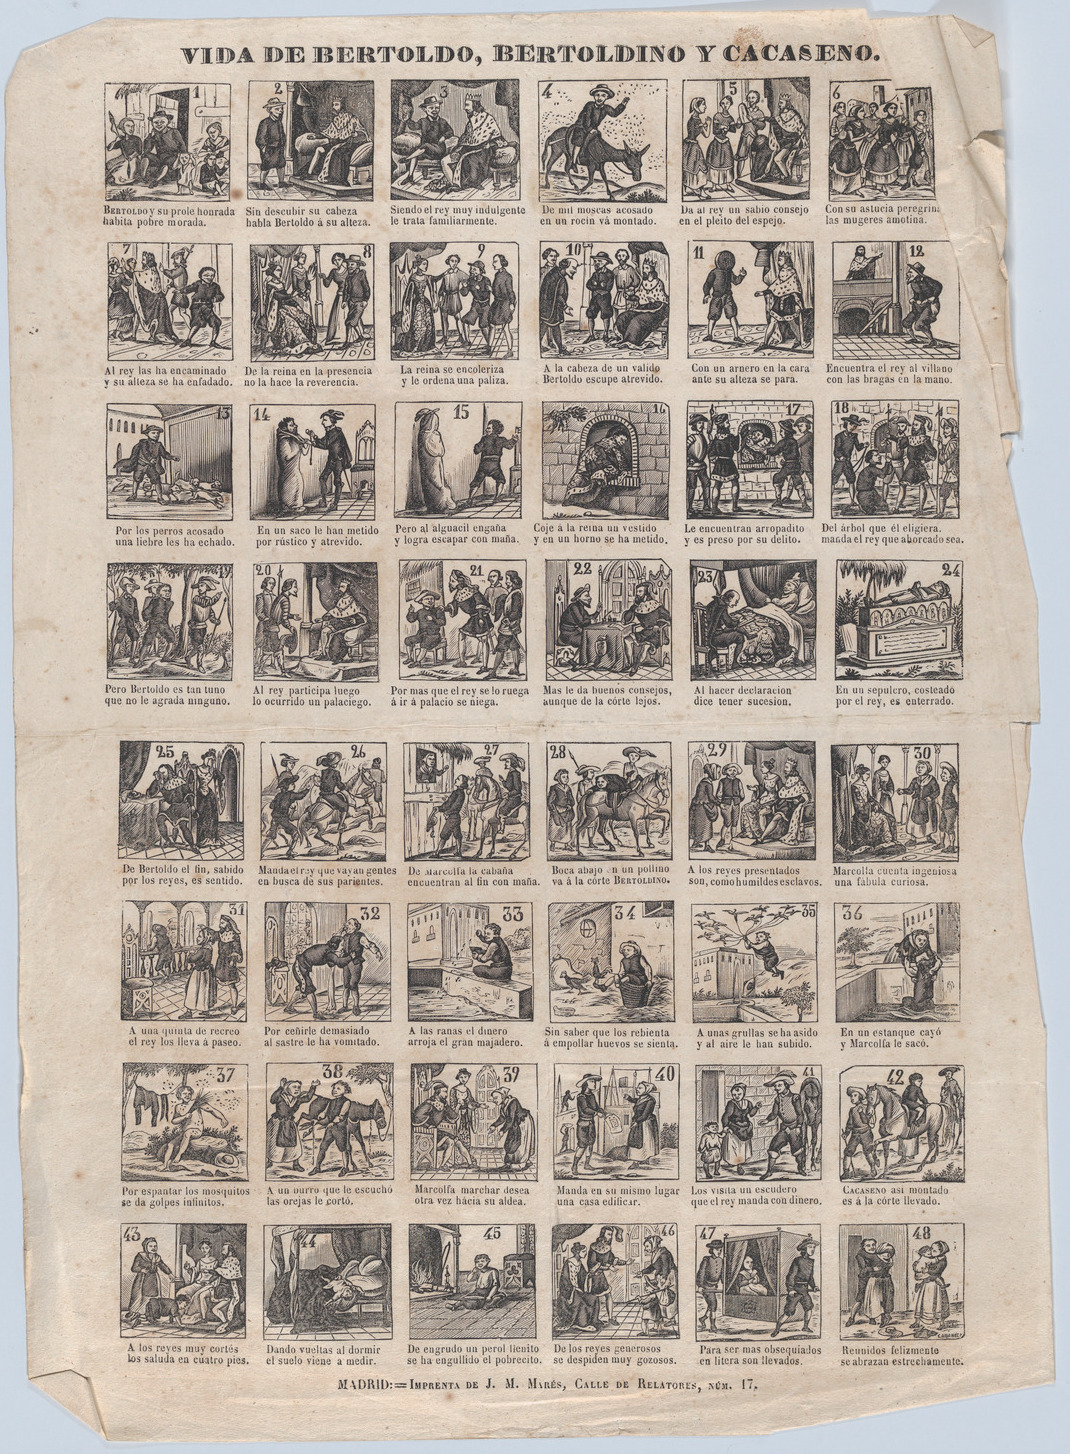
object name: print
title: Broadside with 48 scenes from the lives of Bertoldo, Bertoldino and Cacaseno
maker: josé maría marés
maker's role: publisher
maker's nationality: spanish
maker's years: 1850-1870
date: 1860-1870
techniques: engraving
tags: men,women,horses